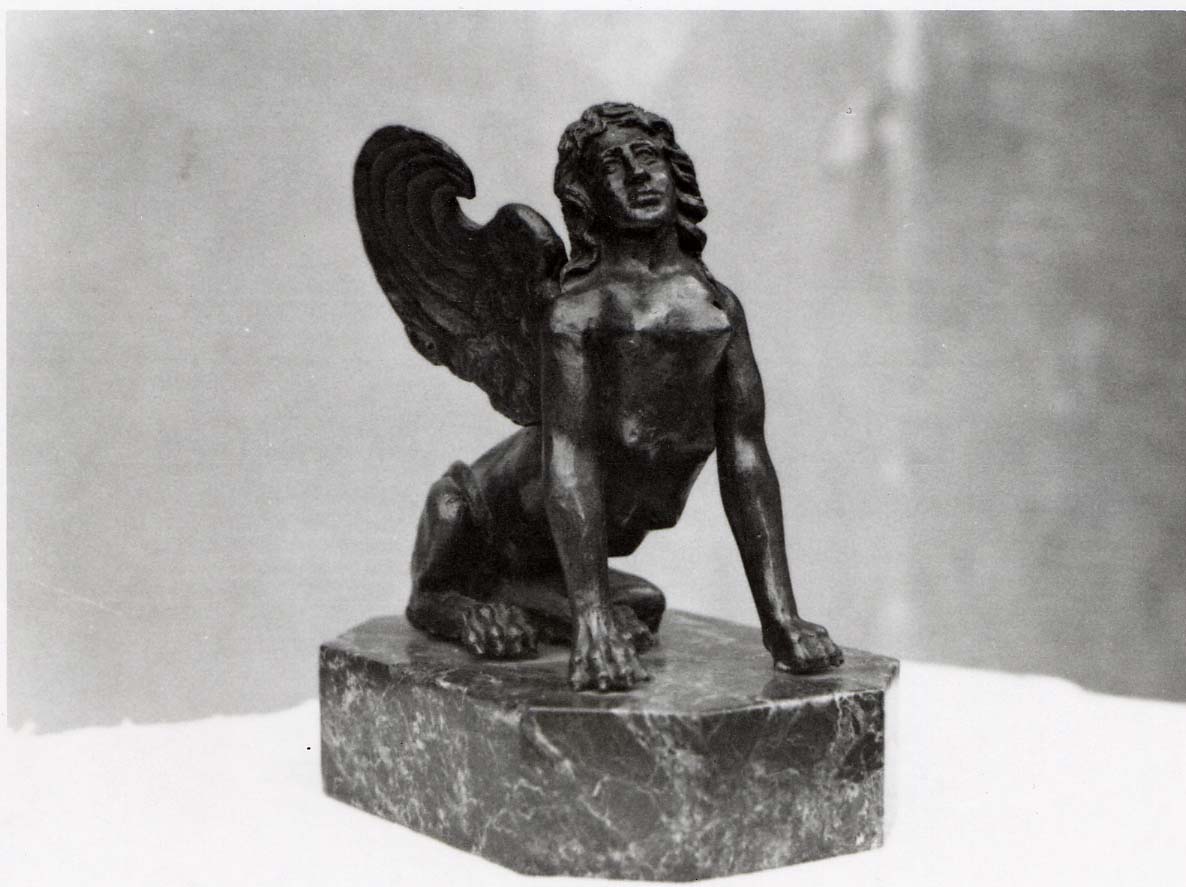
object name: sculpture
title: Winged Sphinx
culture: italian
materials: copper alloy, patina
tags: sphinx